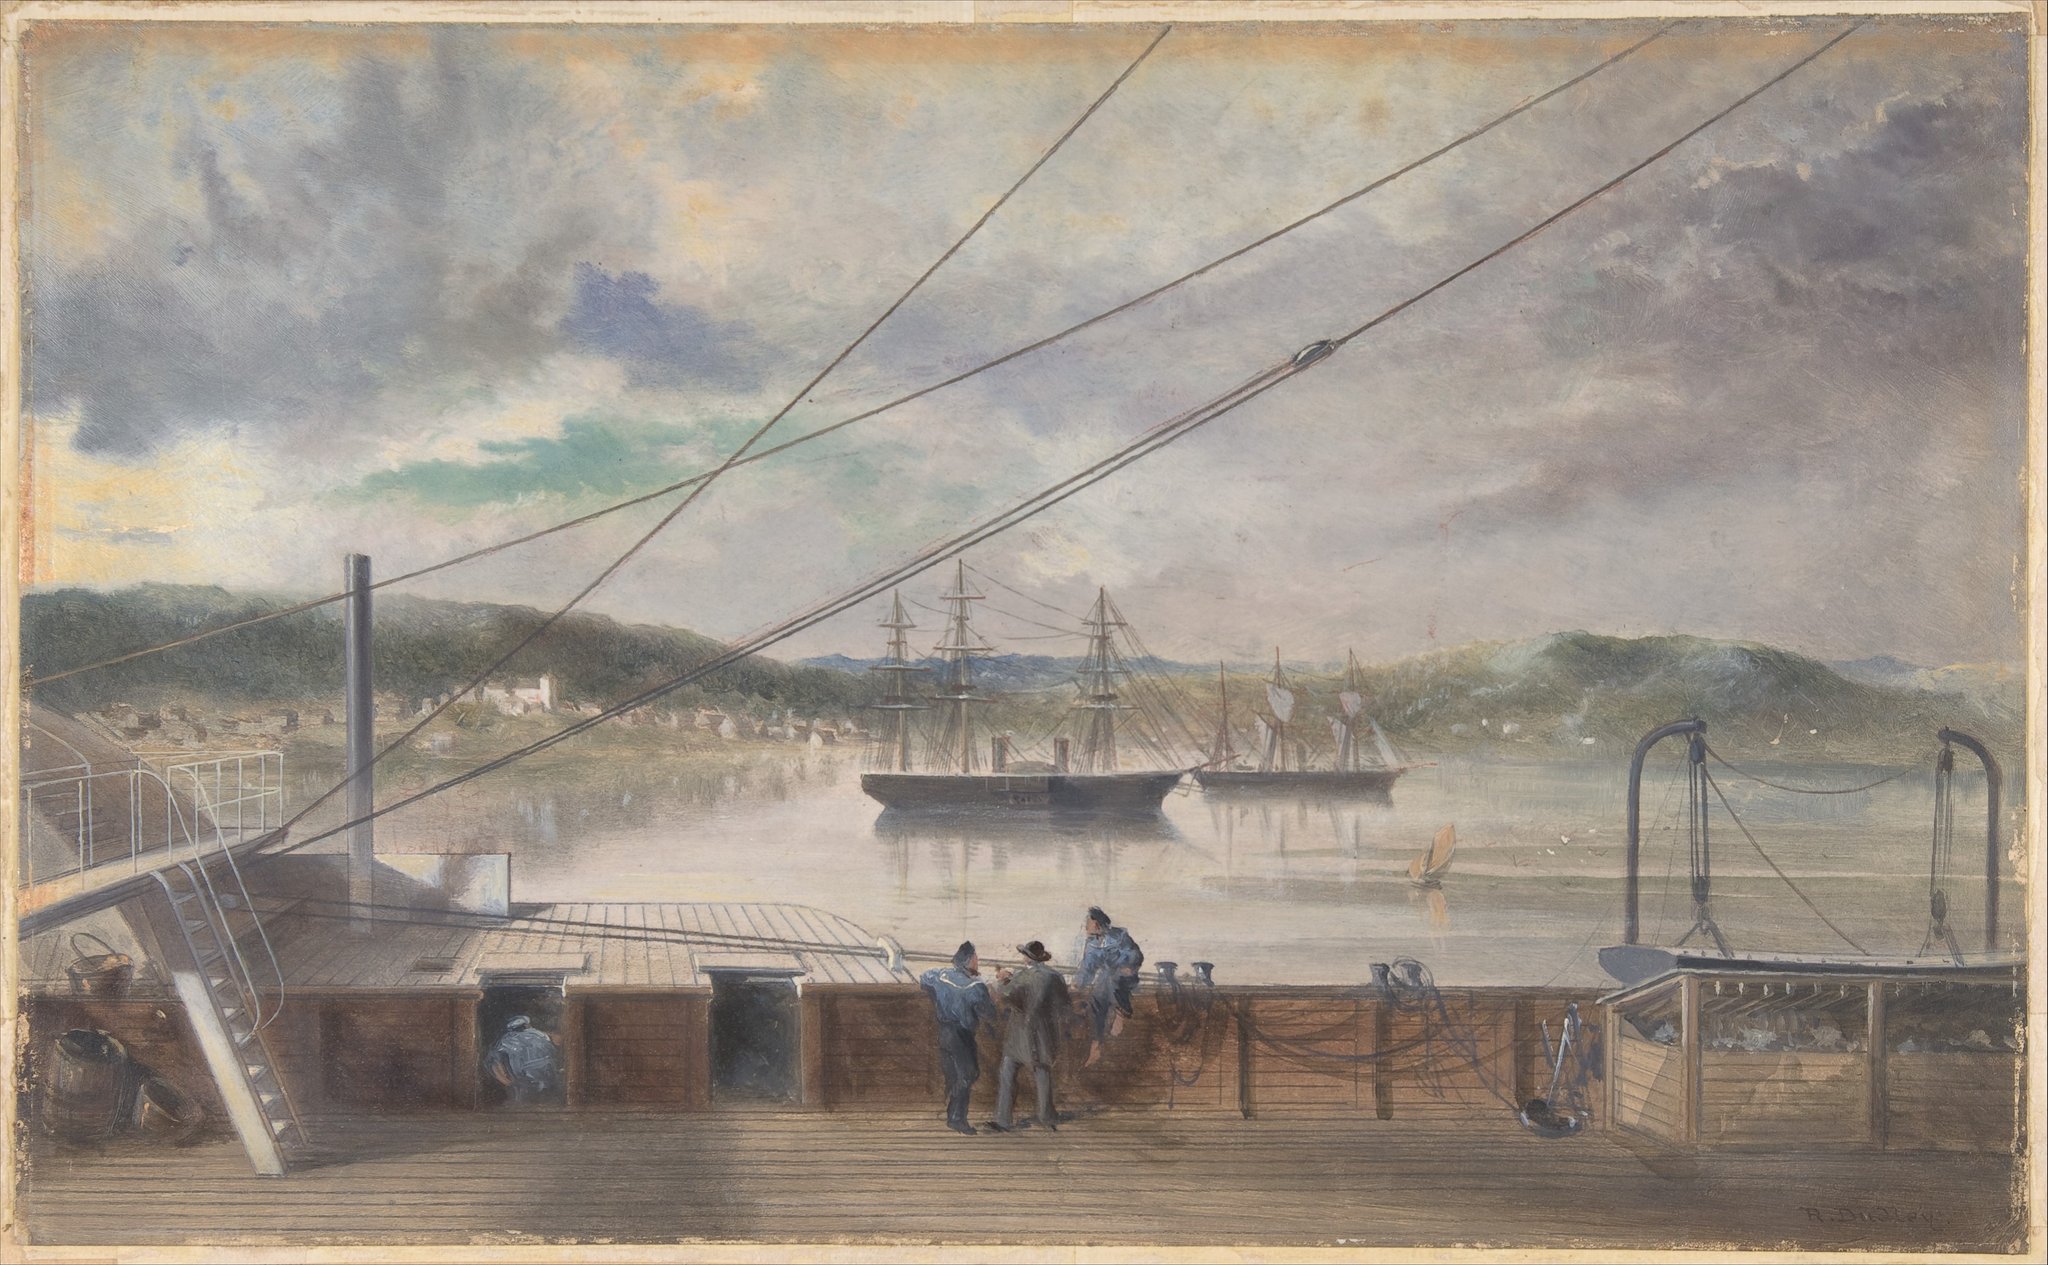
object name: drawing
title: The Settlement and Church of Heart's Content, Newfoundland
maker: robert charles dudley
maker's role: artist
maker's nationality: british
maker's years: 1826-1909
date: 1866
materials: gouache, graphite, watercolor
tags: men,ships,transatlantic cable